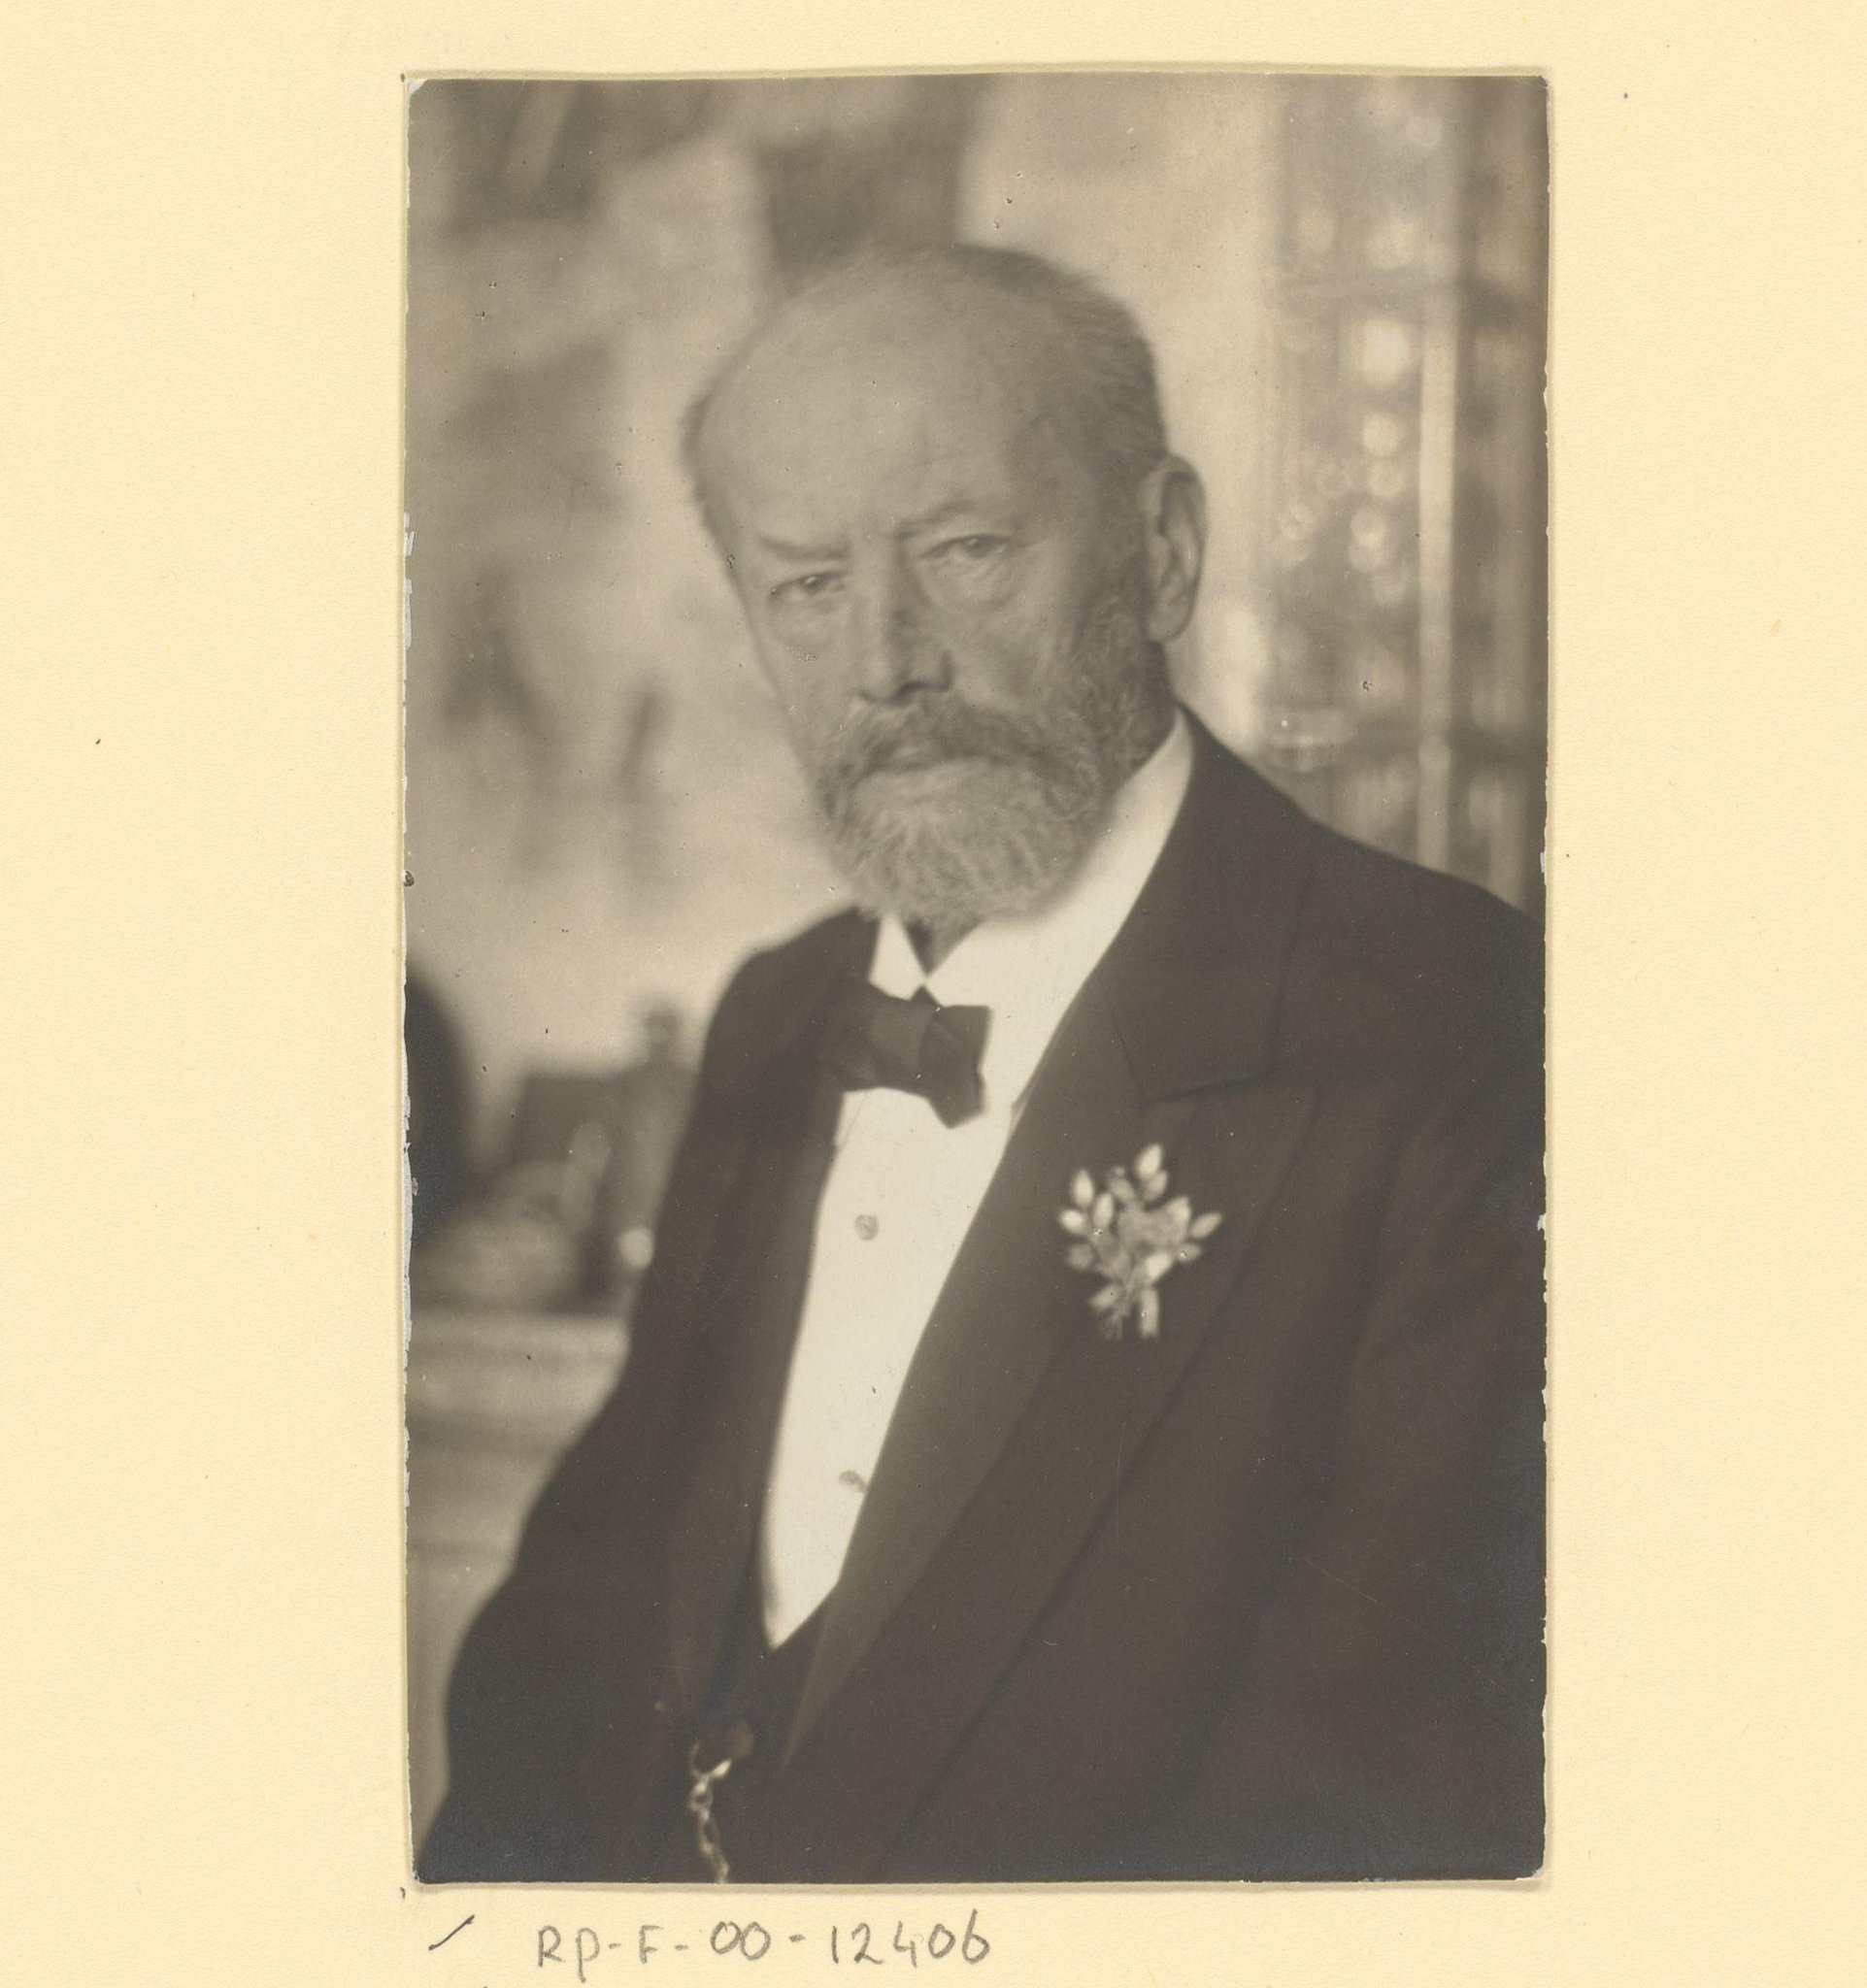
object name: ansichtkaart, prentbriefkaart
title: Portret van professor Lindner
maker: Anonymous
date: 1905-1950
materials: paper, cardboard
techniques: gelatin silver print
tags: historical persons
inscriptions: inscription: ‘Prof Lindner, [...]’